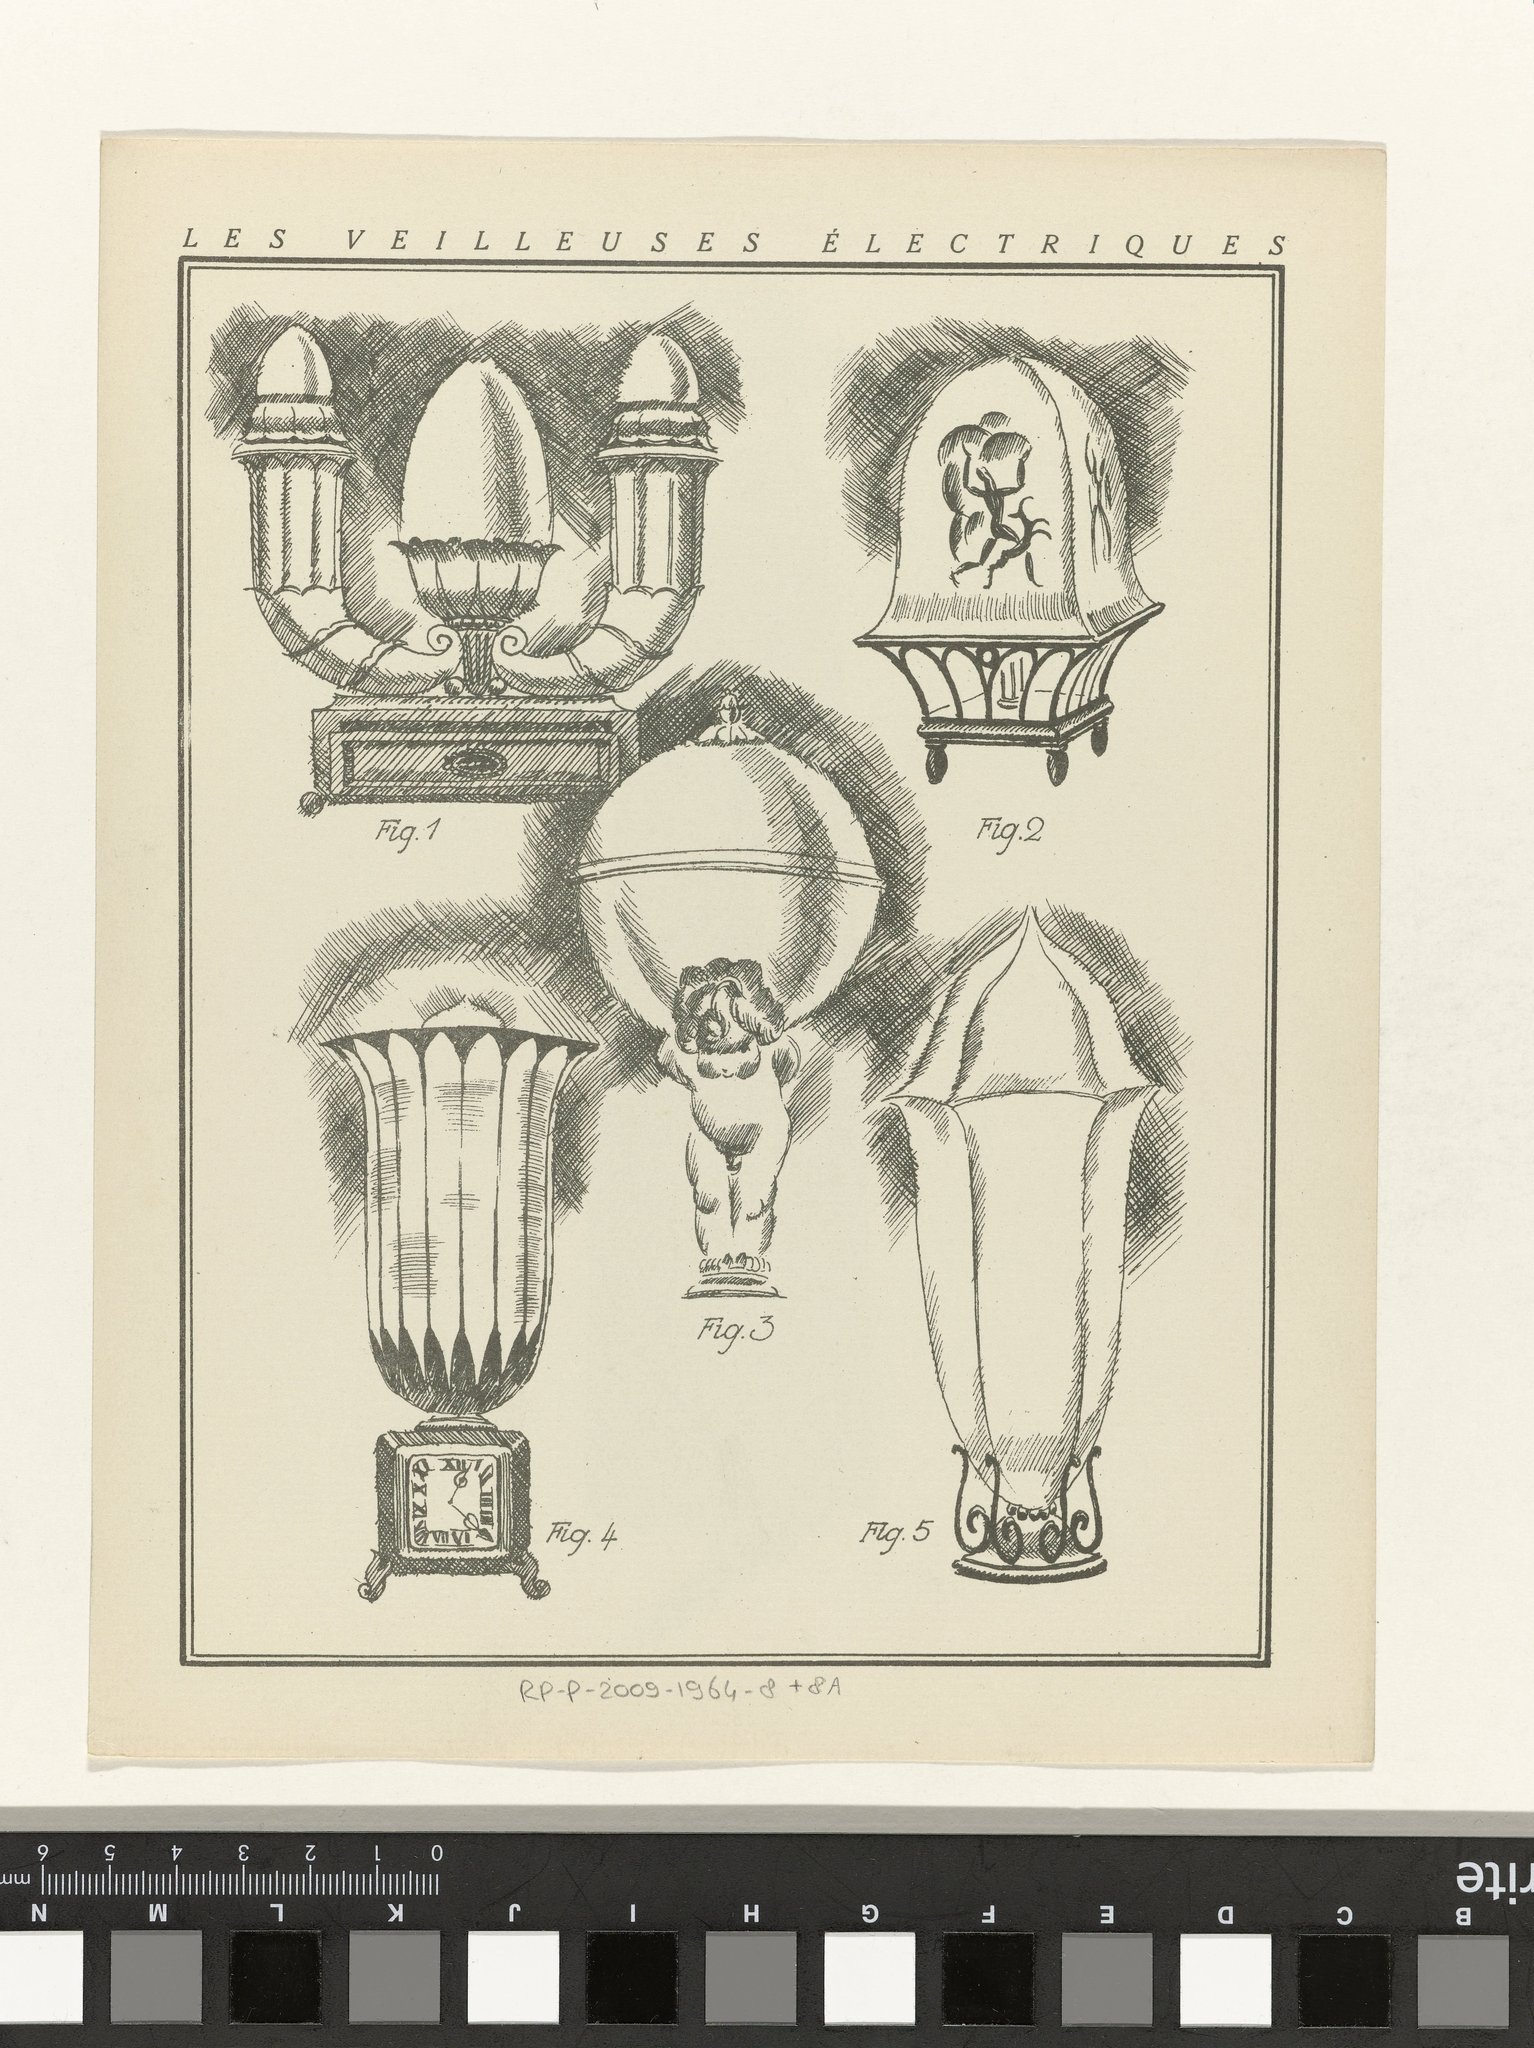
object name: fashion print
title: Gazette du Bon Ton, 1922 - No. 10. Pl. II verso: Les veilleuses électriques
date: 1922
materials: paper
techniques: letterpress printing, lithograph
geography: london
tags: fashion plates, electric lamp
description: Vijf verschillende nachtlampjes. Croquis No. II verso uit Gazette du Bon Ton 1922, No. 10. Uitleg over de lampen op pagina "Description et explication des planches hors-texte et pages de croquis."